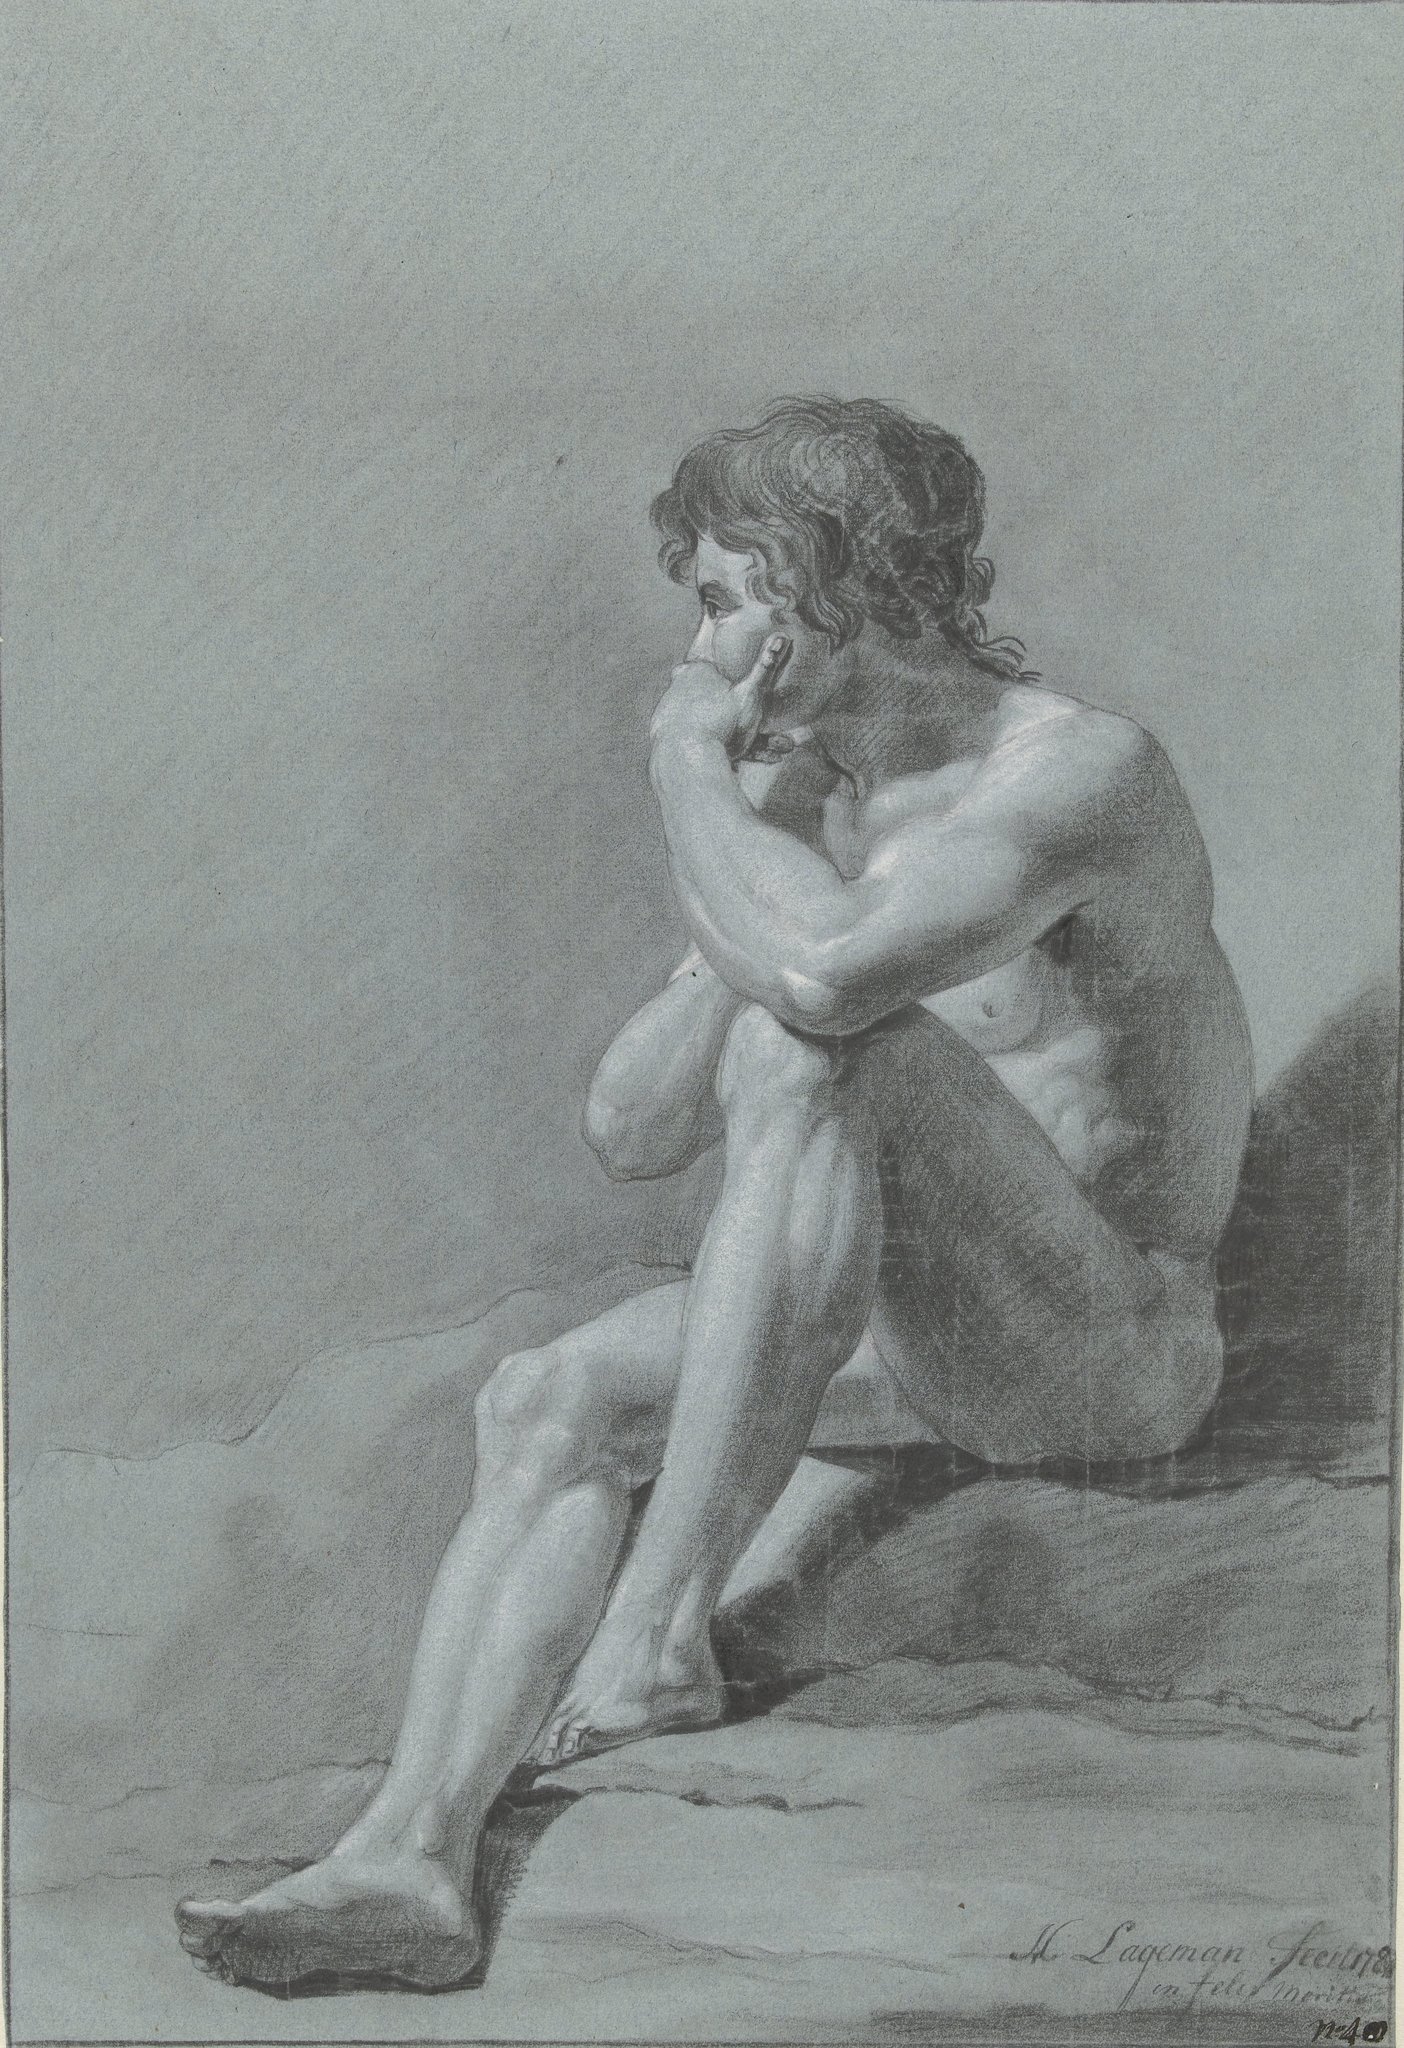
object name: drawing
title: Zittend mannelijk naakt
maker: hendrik lageman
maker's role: draughtsman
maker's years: 1765-1816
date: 1780-1789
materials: chalk, paper